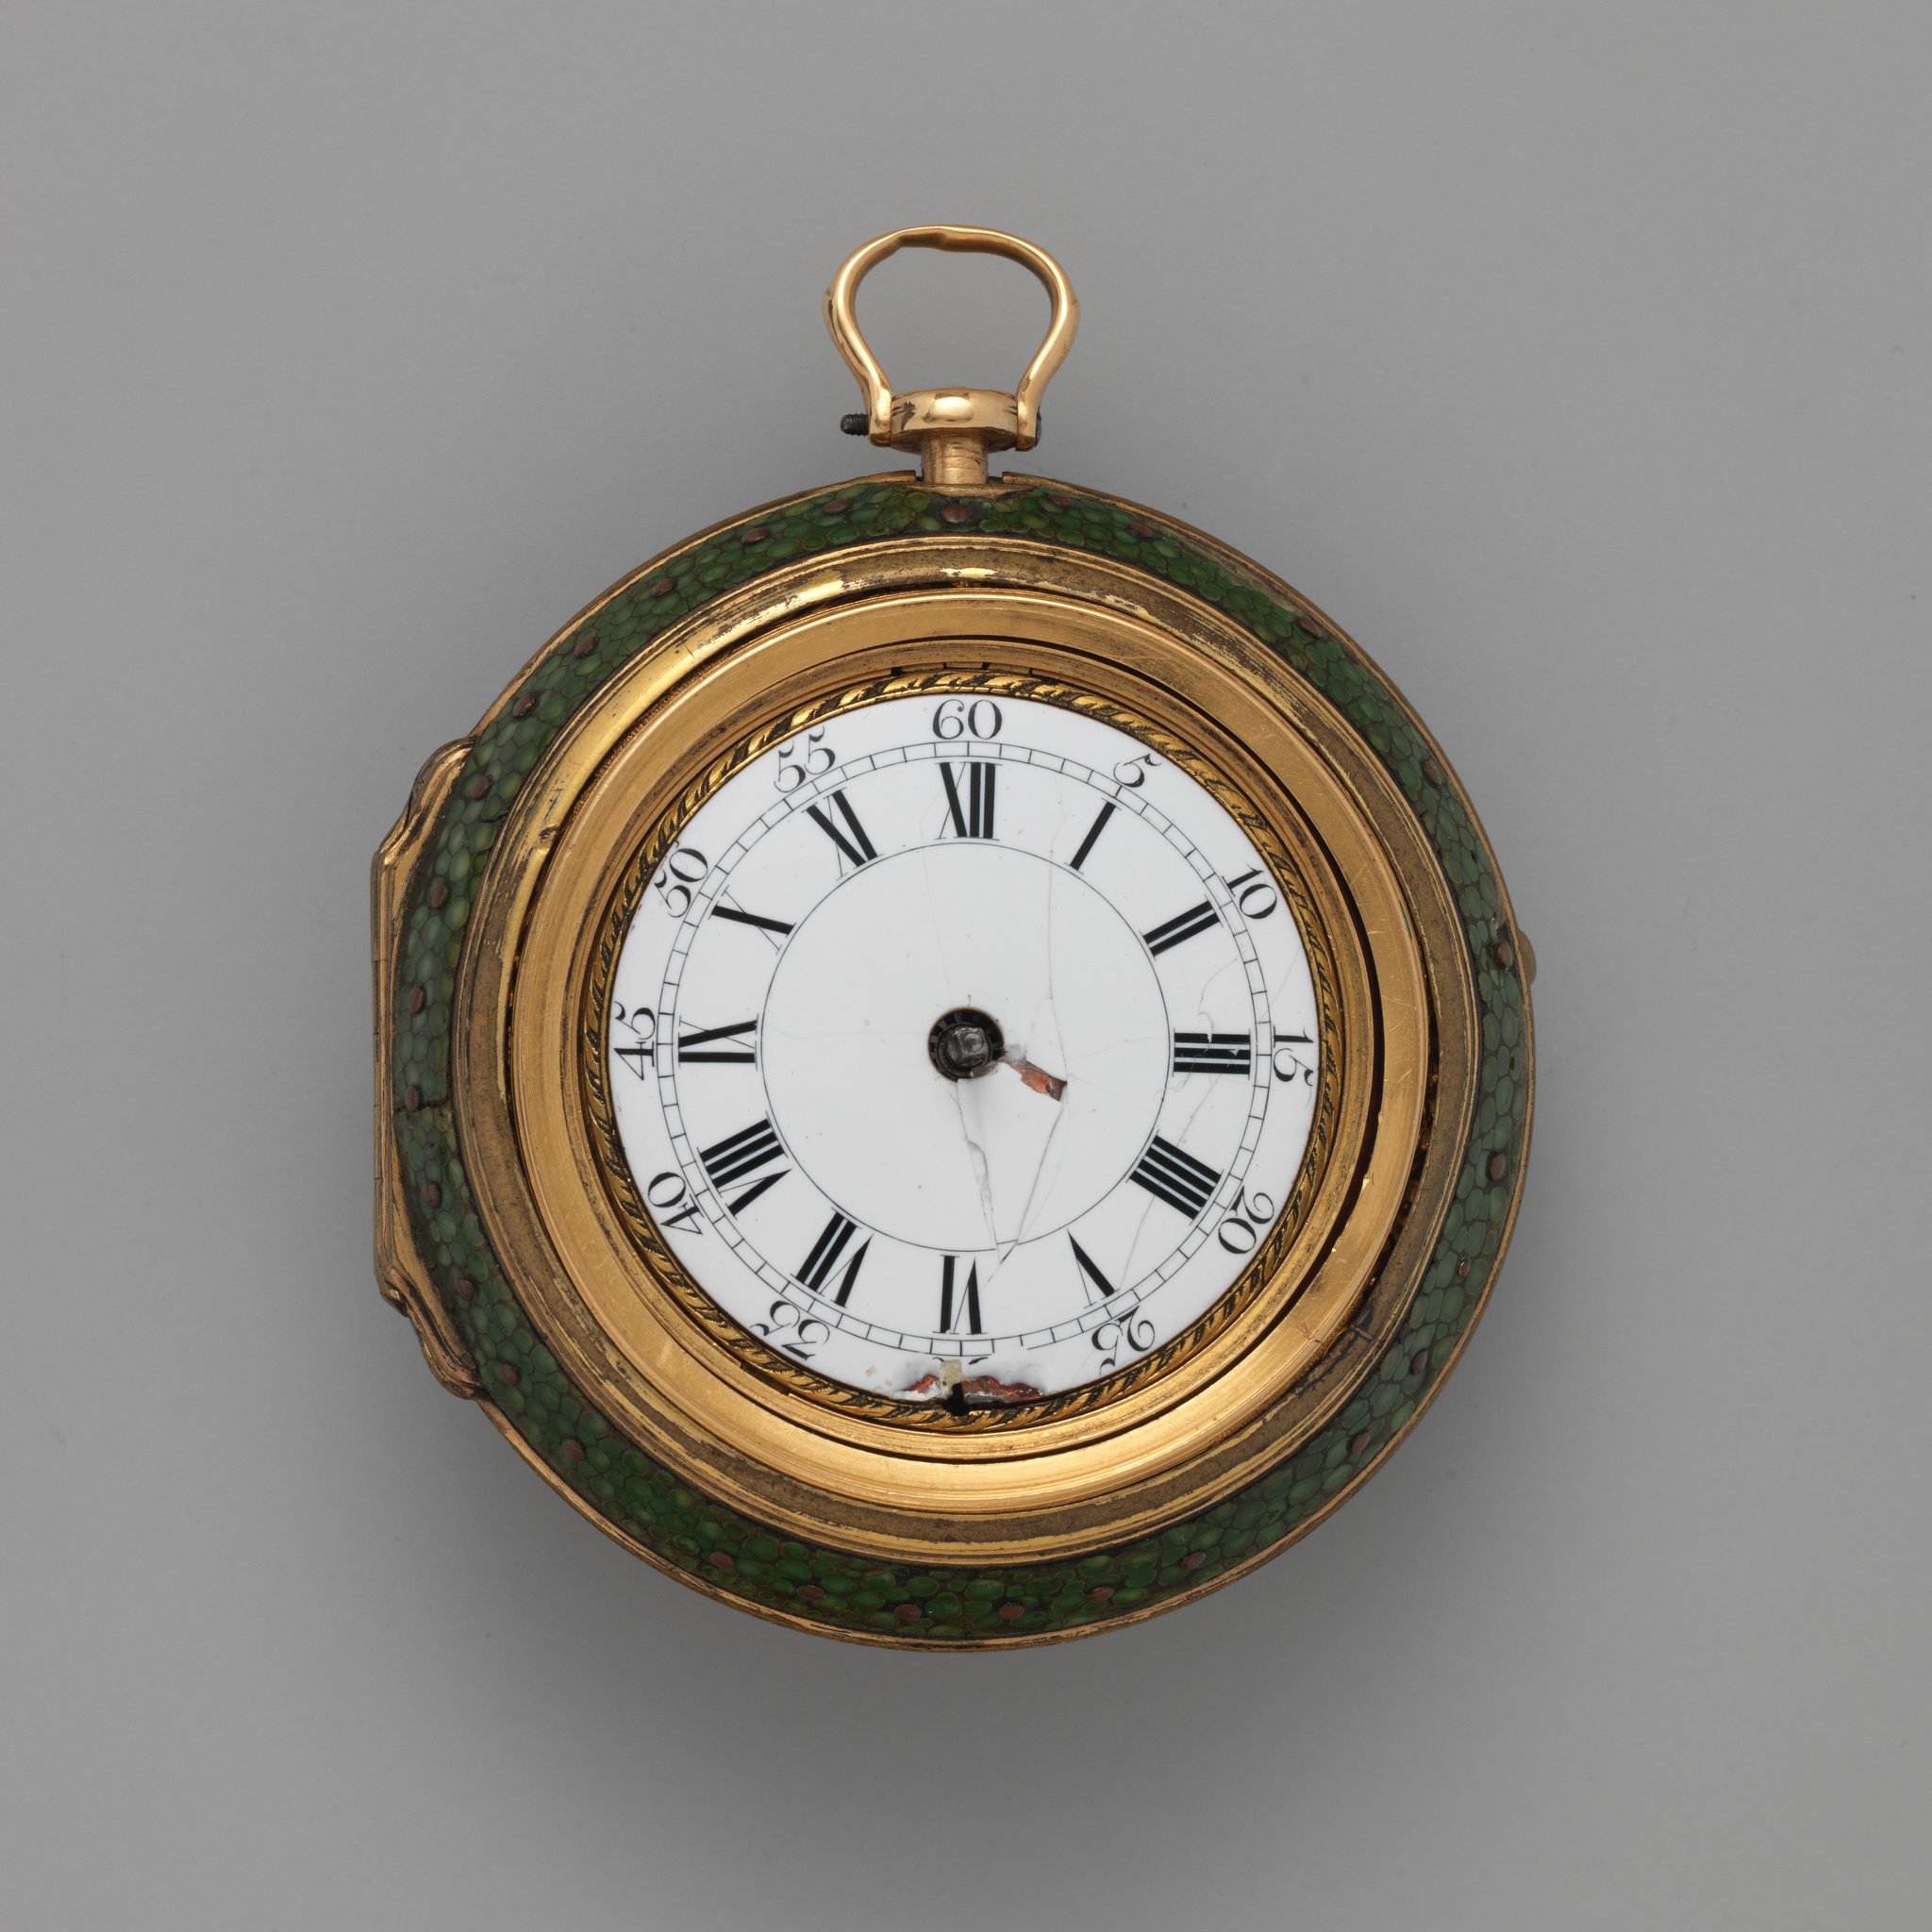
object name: watch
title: Triple-cased watch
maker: firm of clarke & dunster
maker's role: maker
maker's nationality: british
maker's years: 1703-1730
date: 1720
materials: brass, enamel, gilt brass, gold, silver, steel